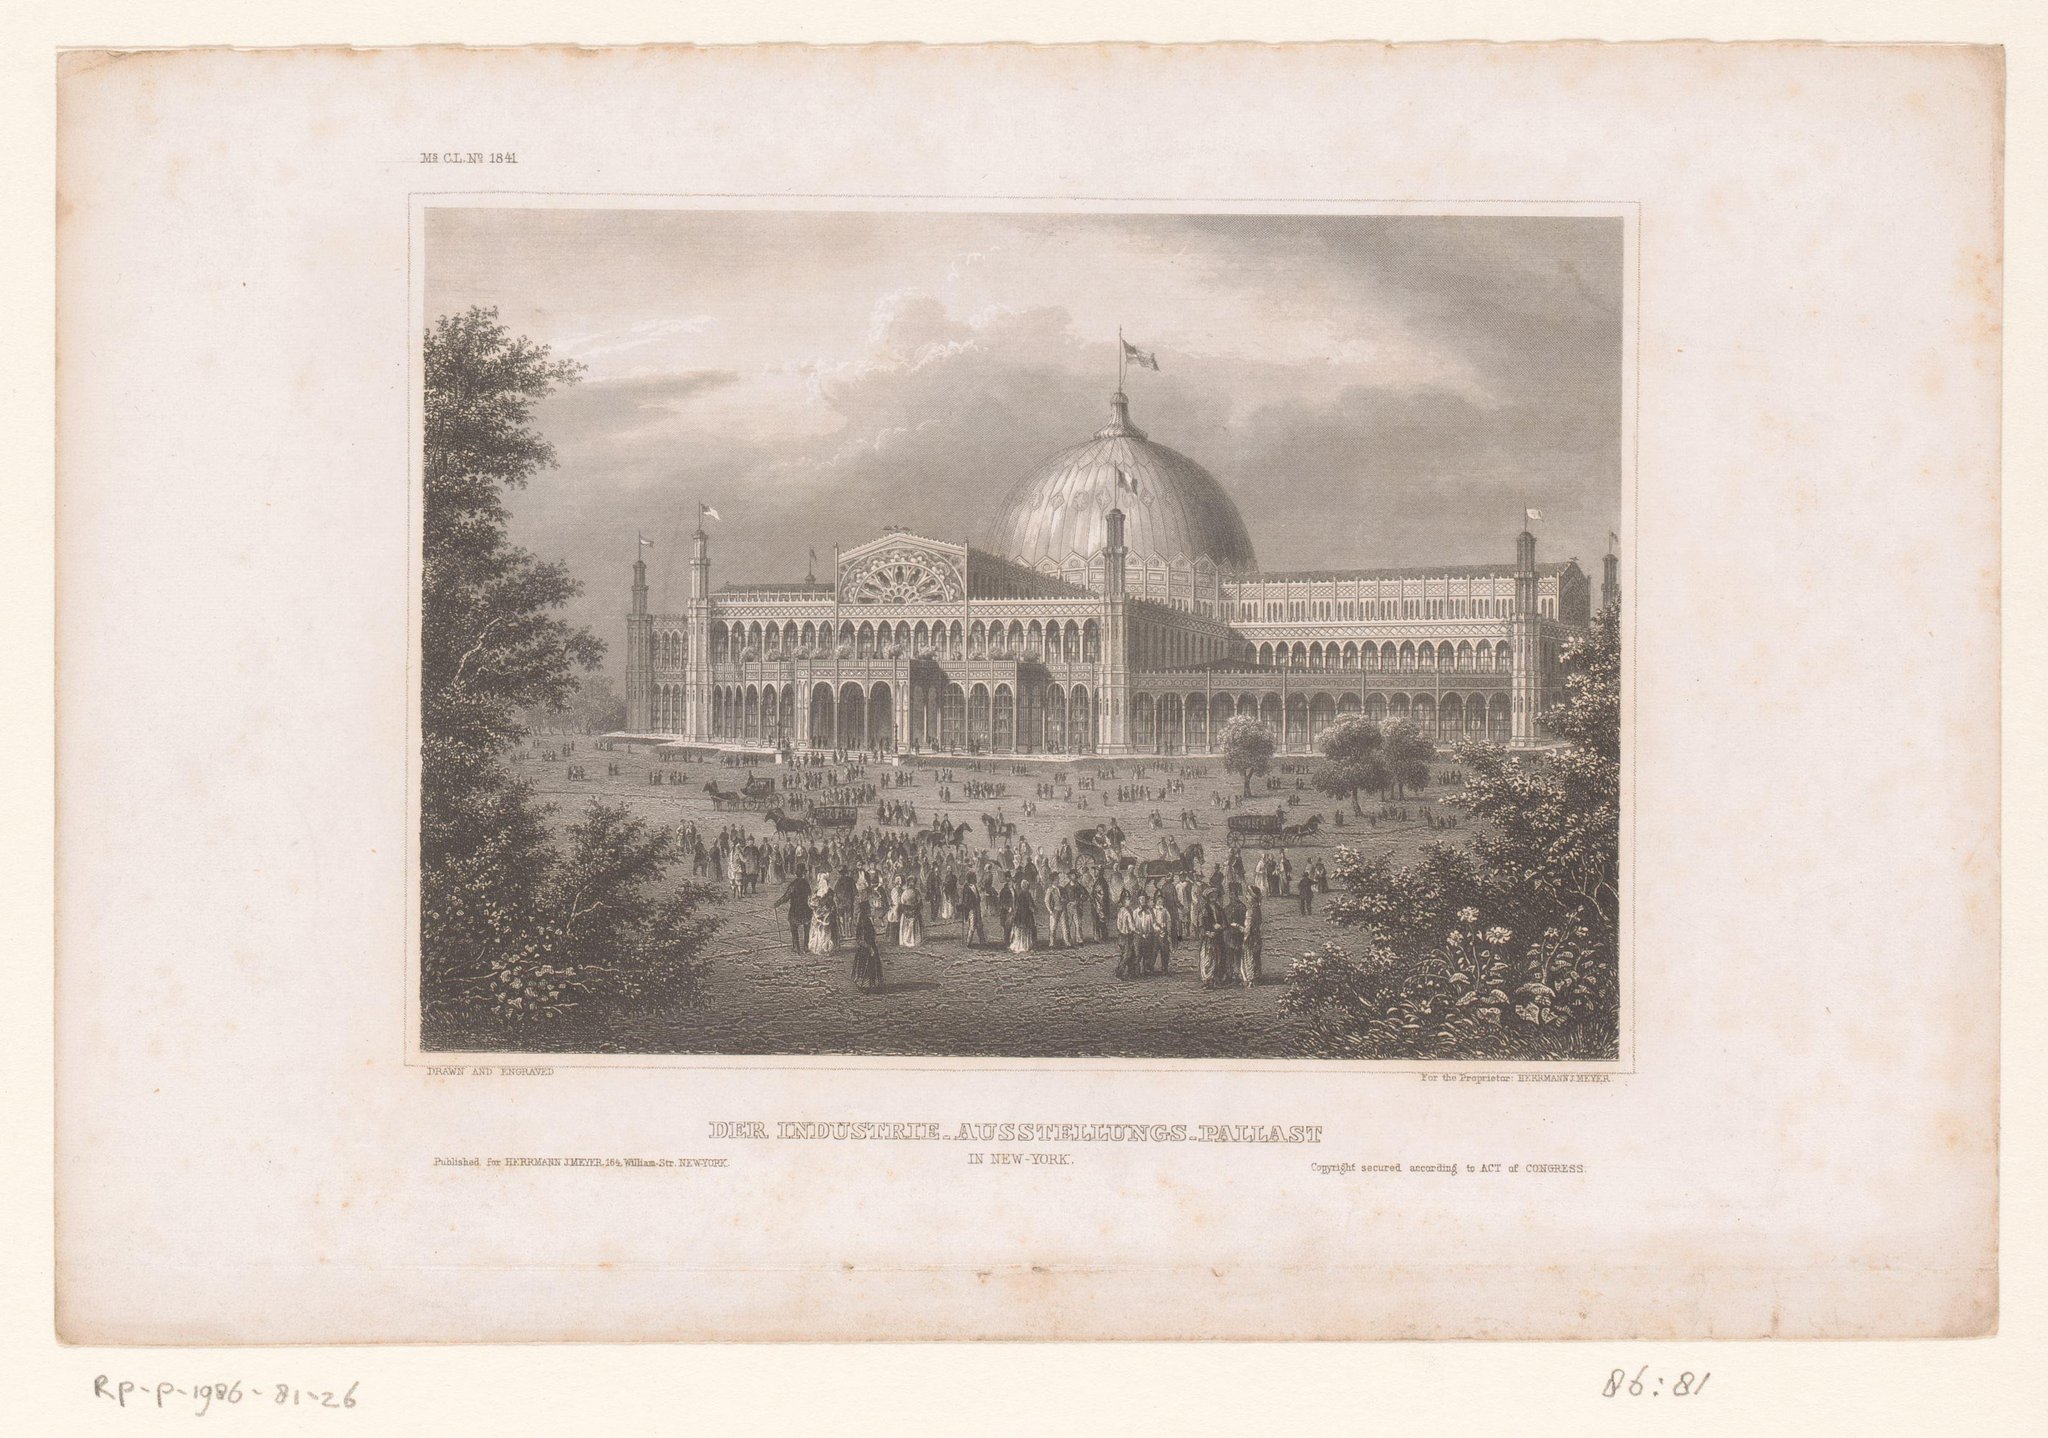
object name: print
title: Gezicht op Crystal Palace, New York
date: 1853-1855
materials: paper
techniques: engraving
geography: new york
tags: palace, new york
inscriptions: collector's mark: Lugt 2760, collector's mark: Lugt 2228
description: Gezicht op Crystal Palace in New York met een massa mensen op de voorgrond. Crystal Palace is in 1853 het gebouw voor de wereldtentoonstelling in New York.